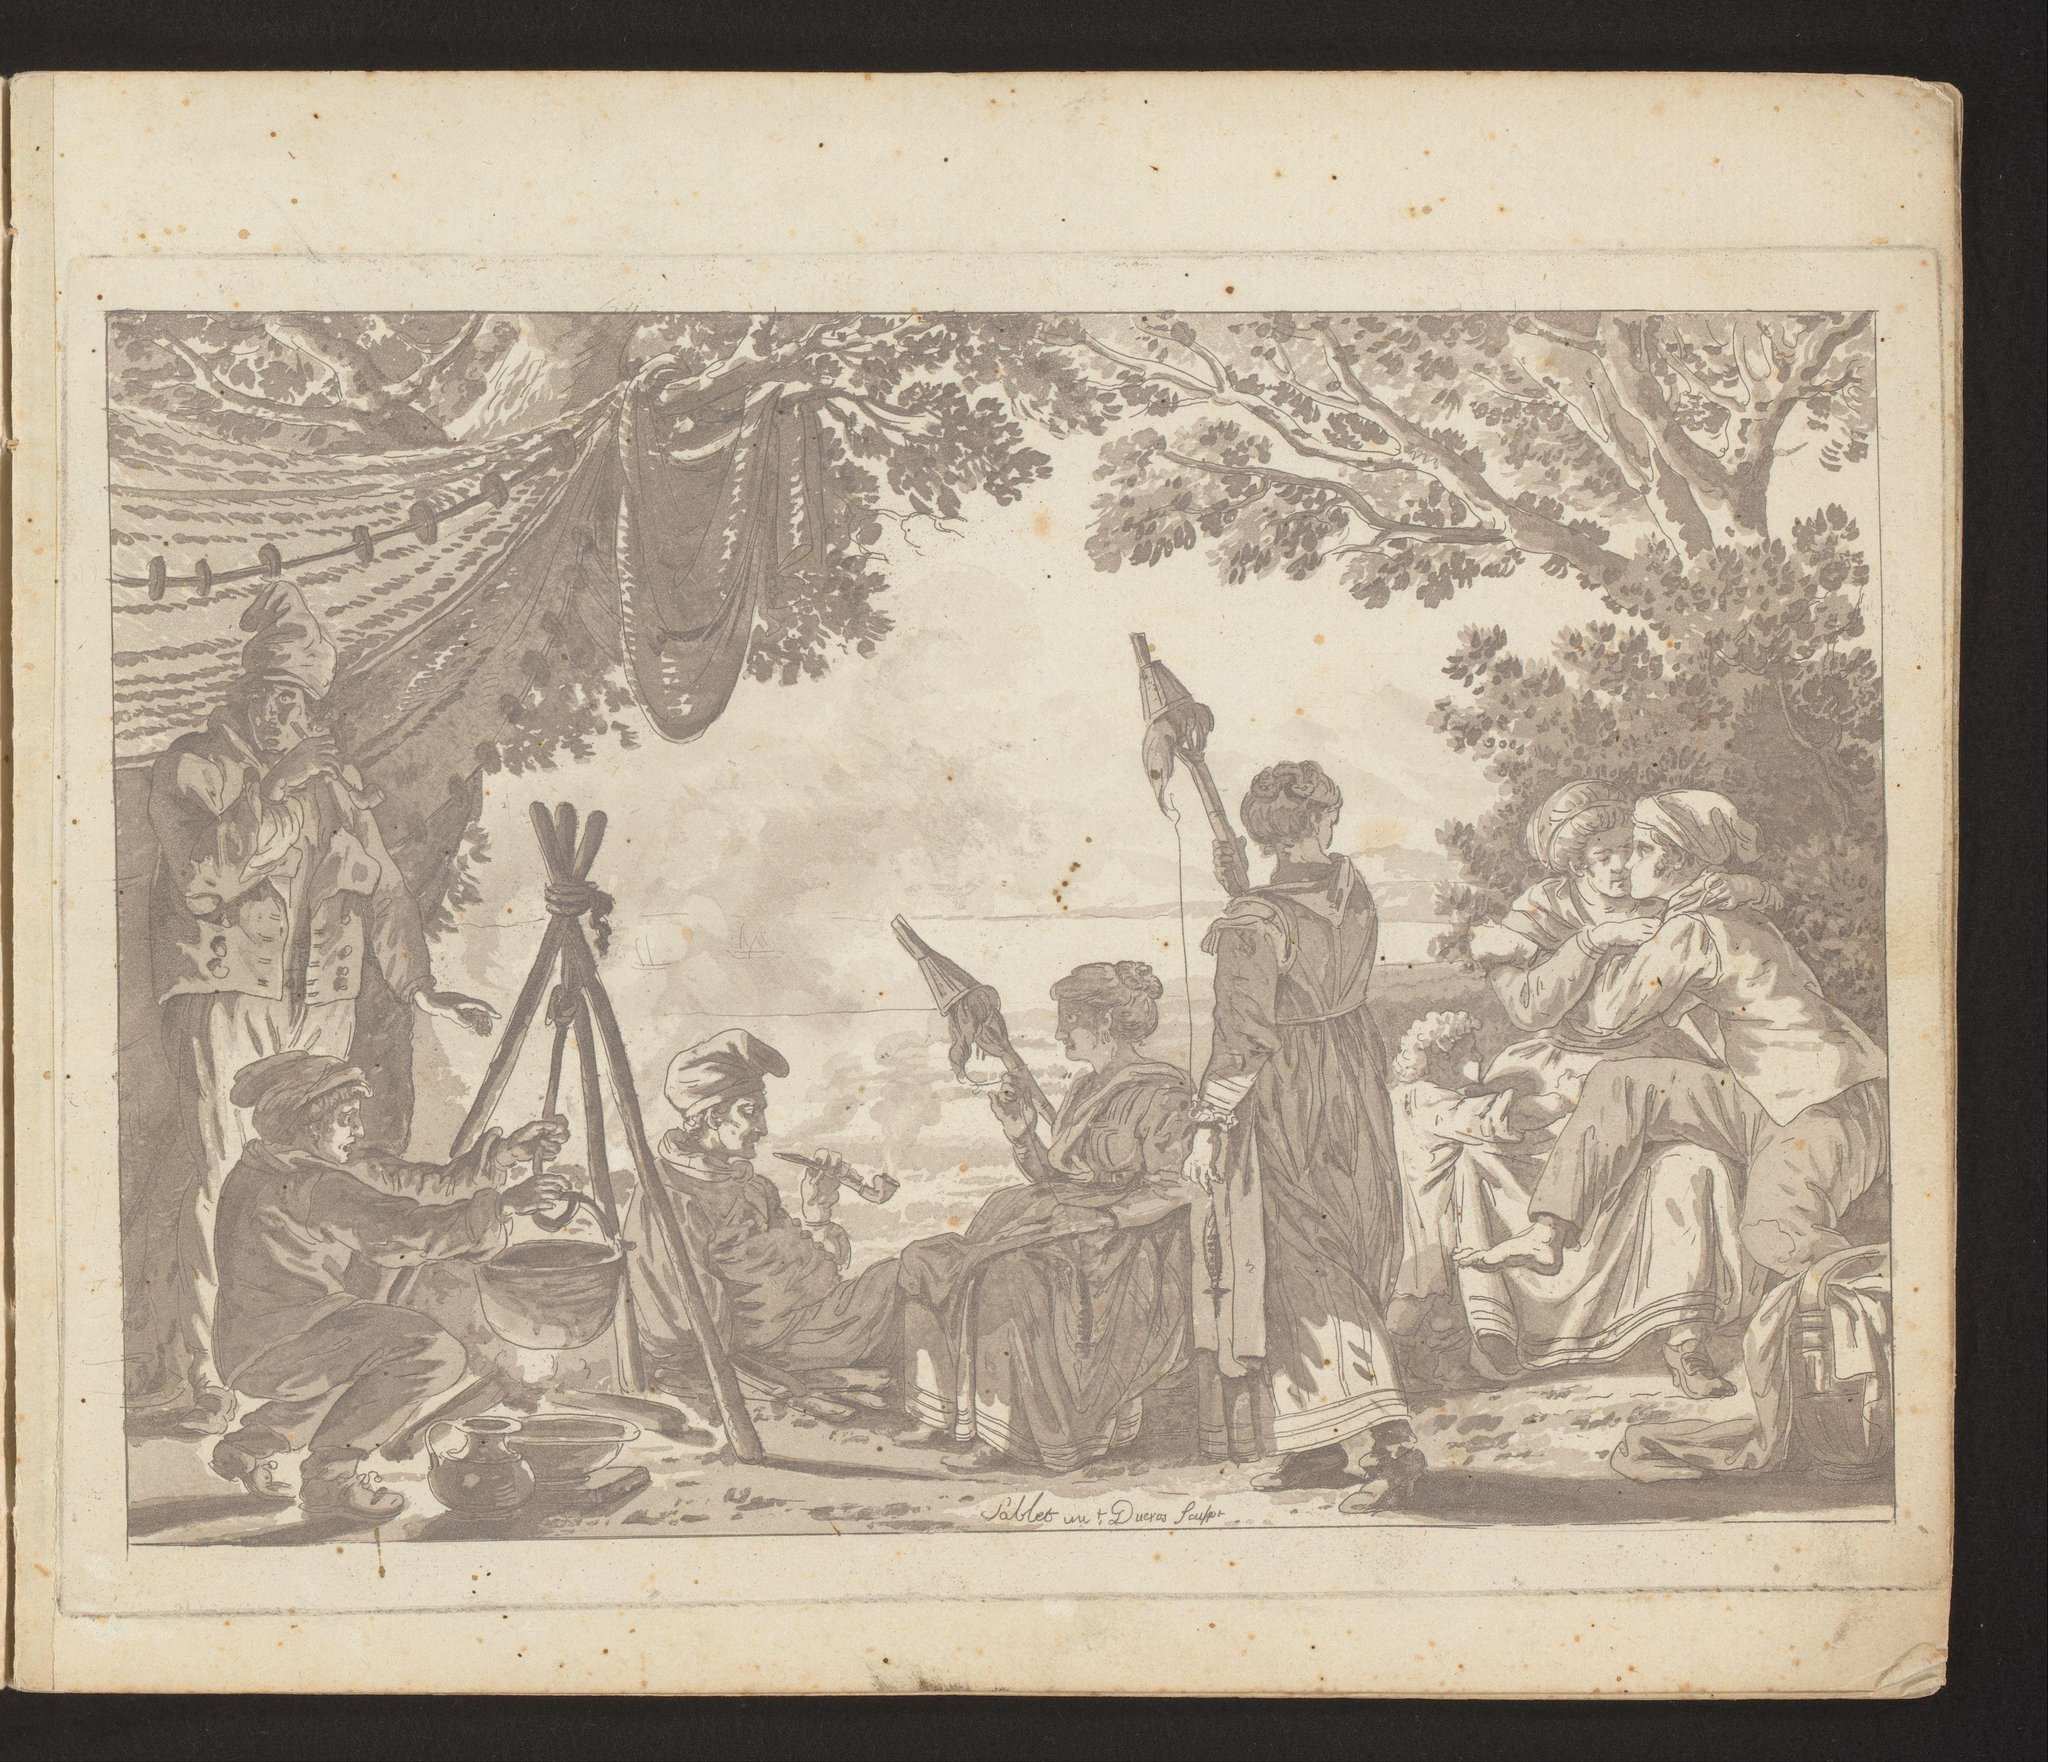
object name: print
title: Gezelschap met vissers en spinsters aan de kust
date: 1758-1810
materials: paper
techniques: aquatint, etching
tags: fishing net, distaff, europeans (with name), fisherman, sea and coastal fishery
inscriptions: collector's mark: Lugt 2760, collector's mark: Lugt 2228